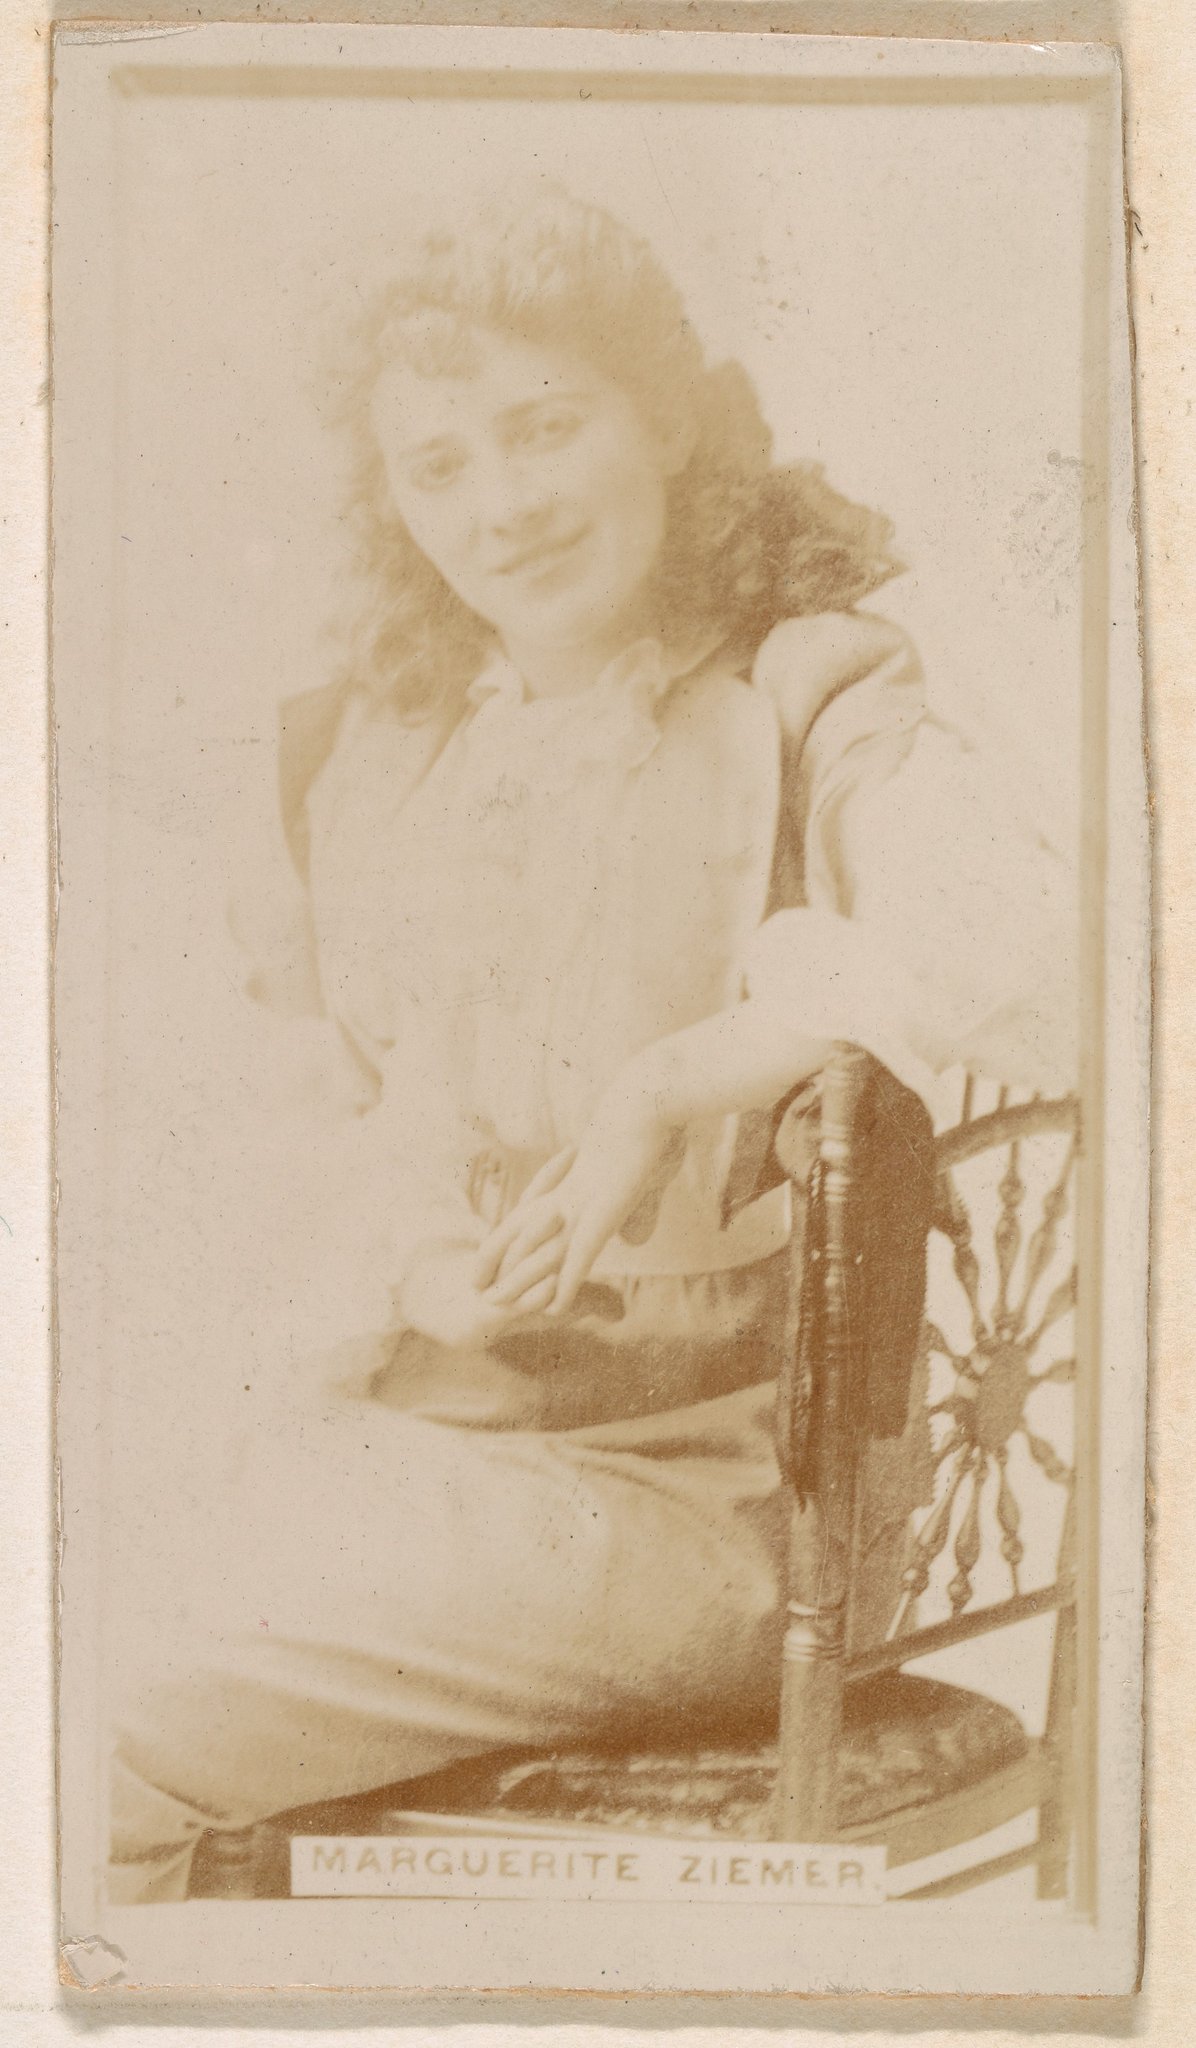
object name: photograph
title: Marguerite Ziemer, from the Actresses series (N245) issued by Kinney Brothers to promote Sweet Caporal Cigarettes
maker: kinney brothers tobacco company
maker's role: publisher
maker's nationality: american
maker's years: 1869-2011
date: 1890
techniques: albumen silver print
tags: portraits,women,actresses